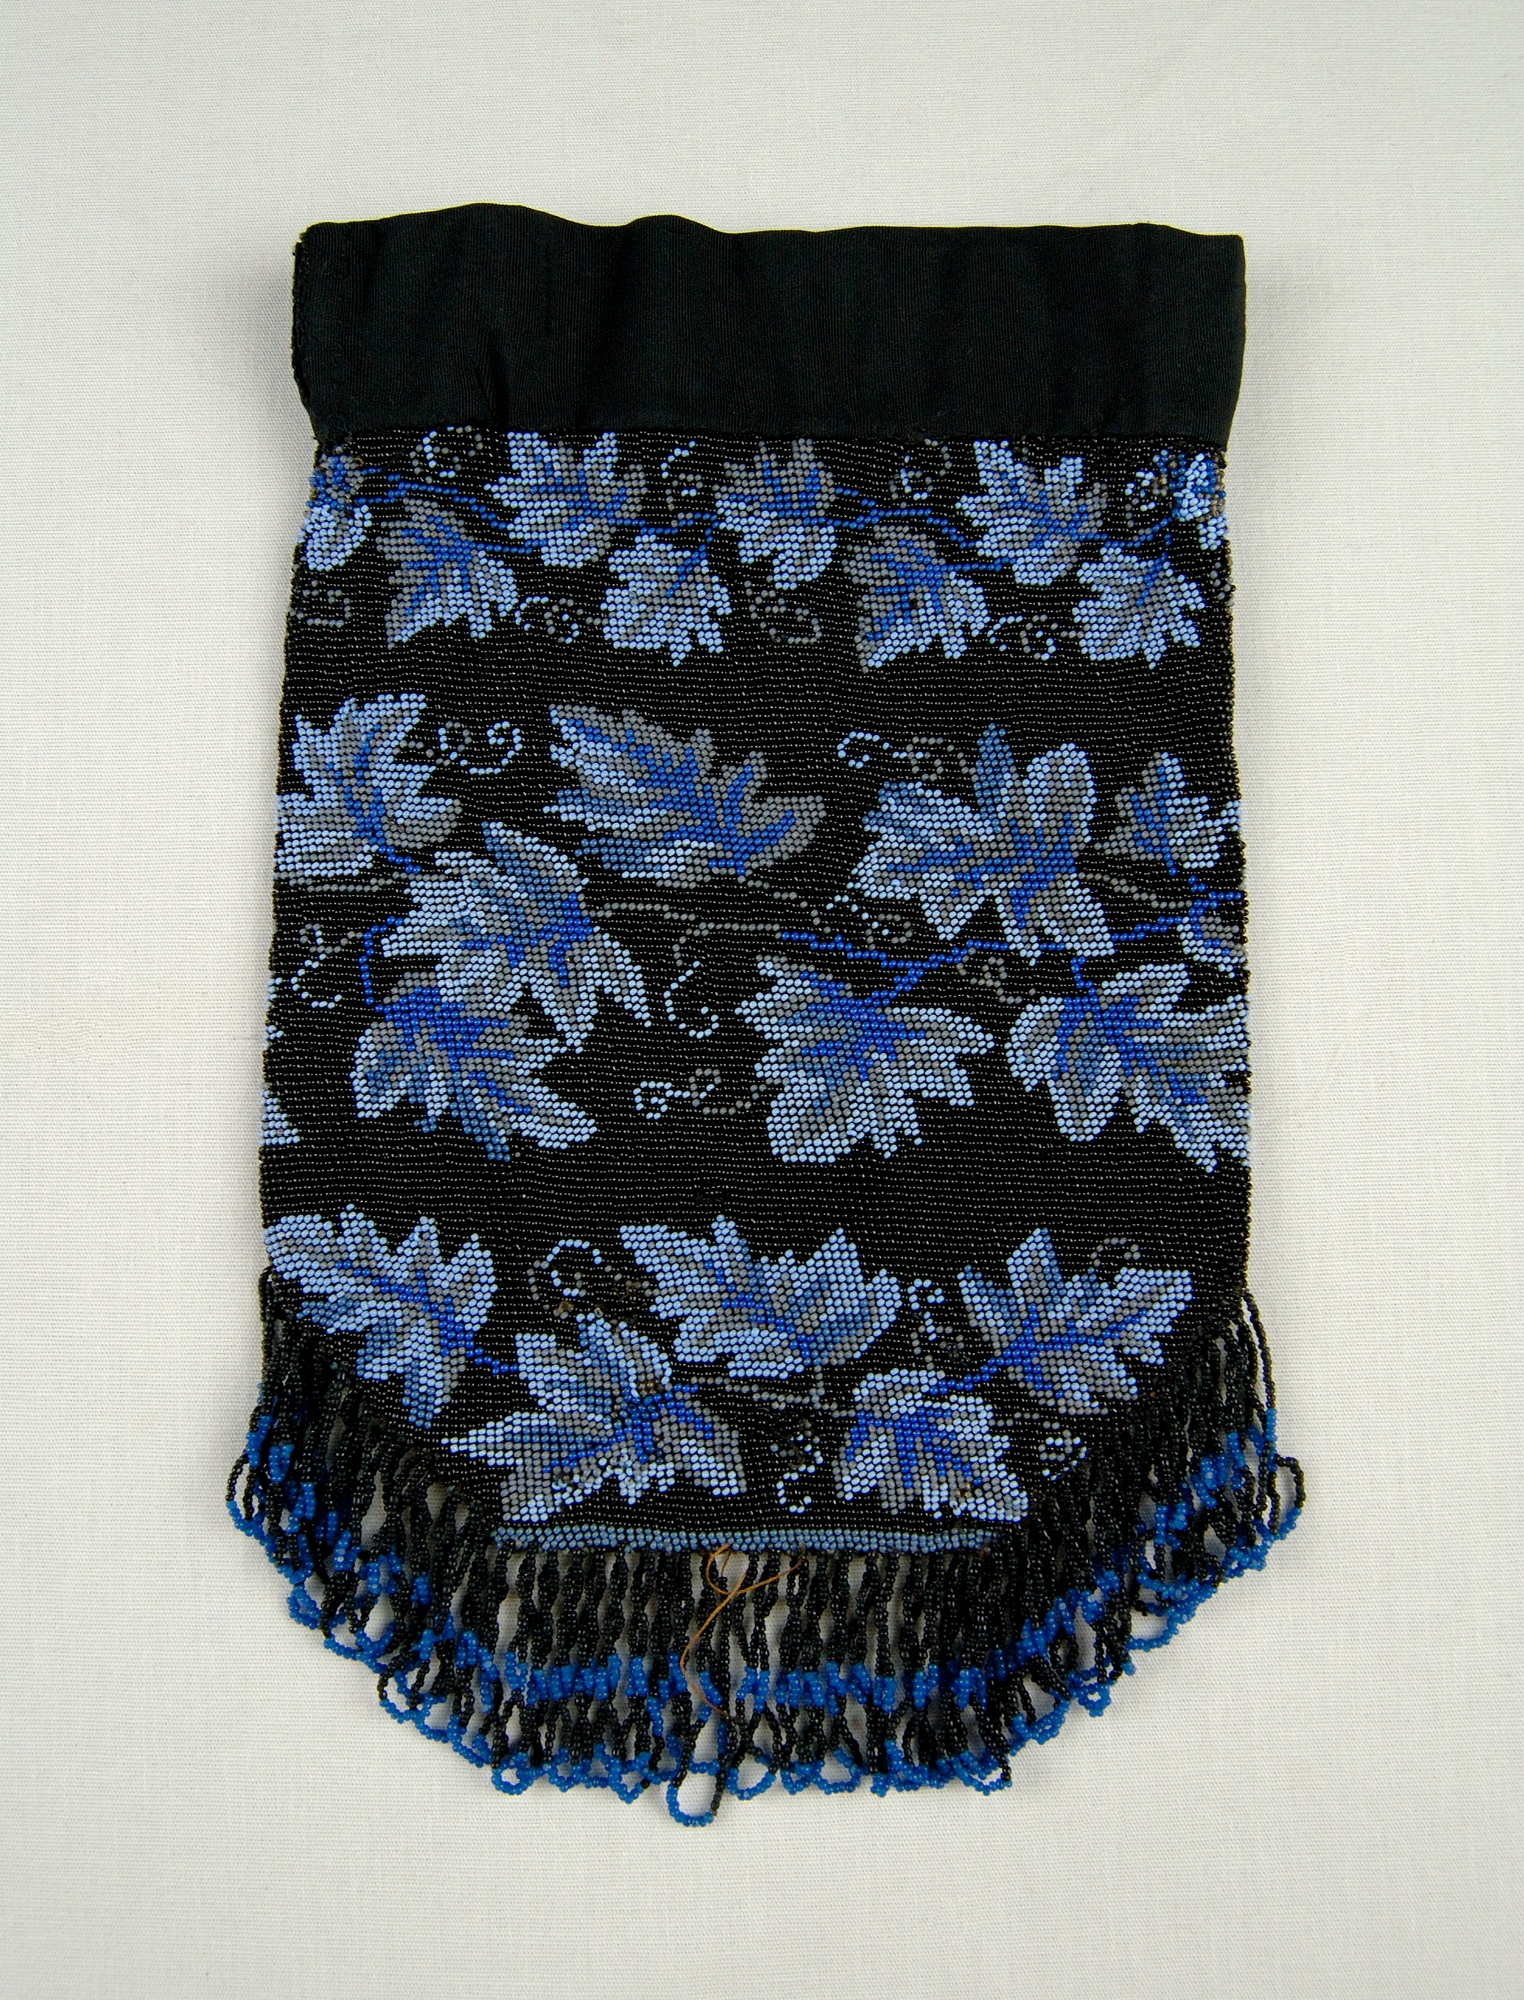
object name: pouch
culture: american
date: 1876-1900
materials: glass, linen, silk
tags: leaves